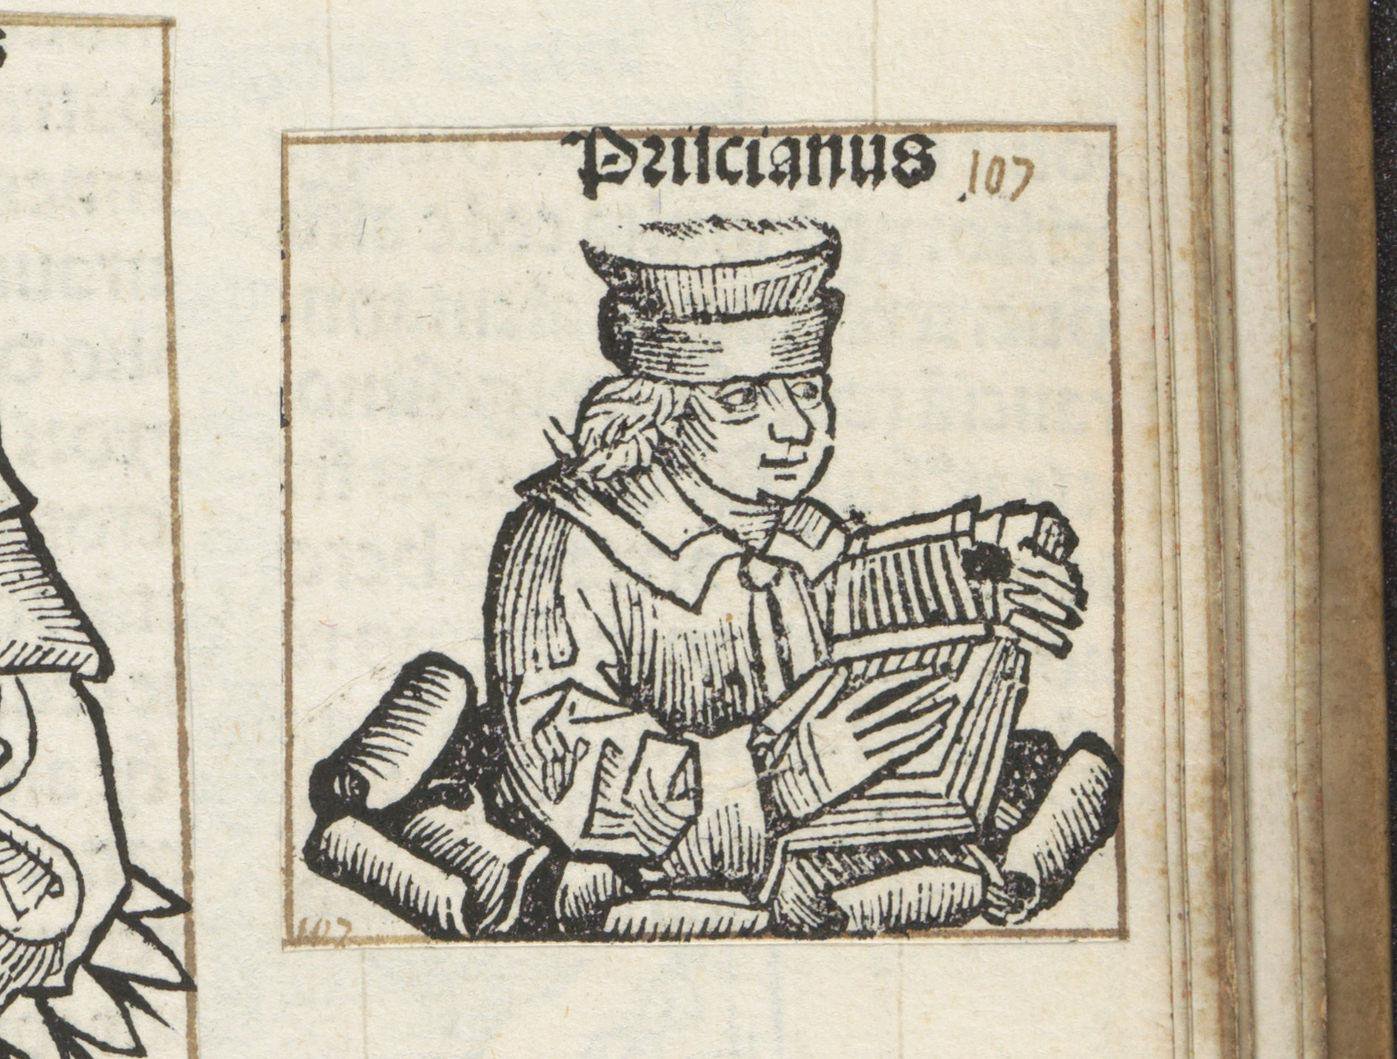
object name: print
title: Liber Chronicarum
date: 1493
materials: paper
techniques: letterpress printing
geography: nuremberg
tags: male persons from classical history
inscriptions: inscription: ‘107’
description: De houtsnede wordt herhaaldelijk gebruikt als boekillustratie in de Liber Chronicarum (of Neurenbergkroniek) van Hartmann Schedel, verschenen in het Latijn en Duits in 1493. Zie de Latijnse uitgave, folio 143v.